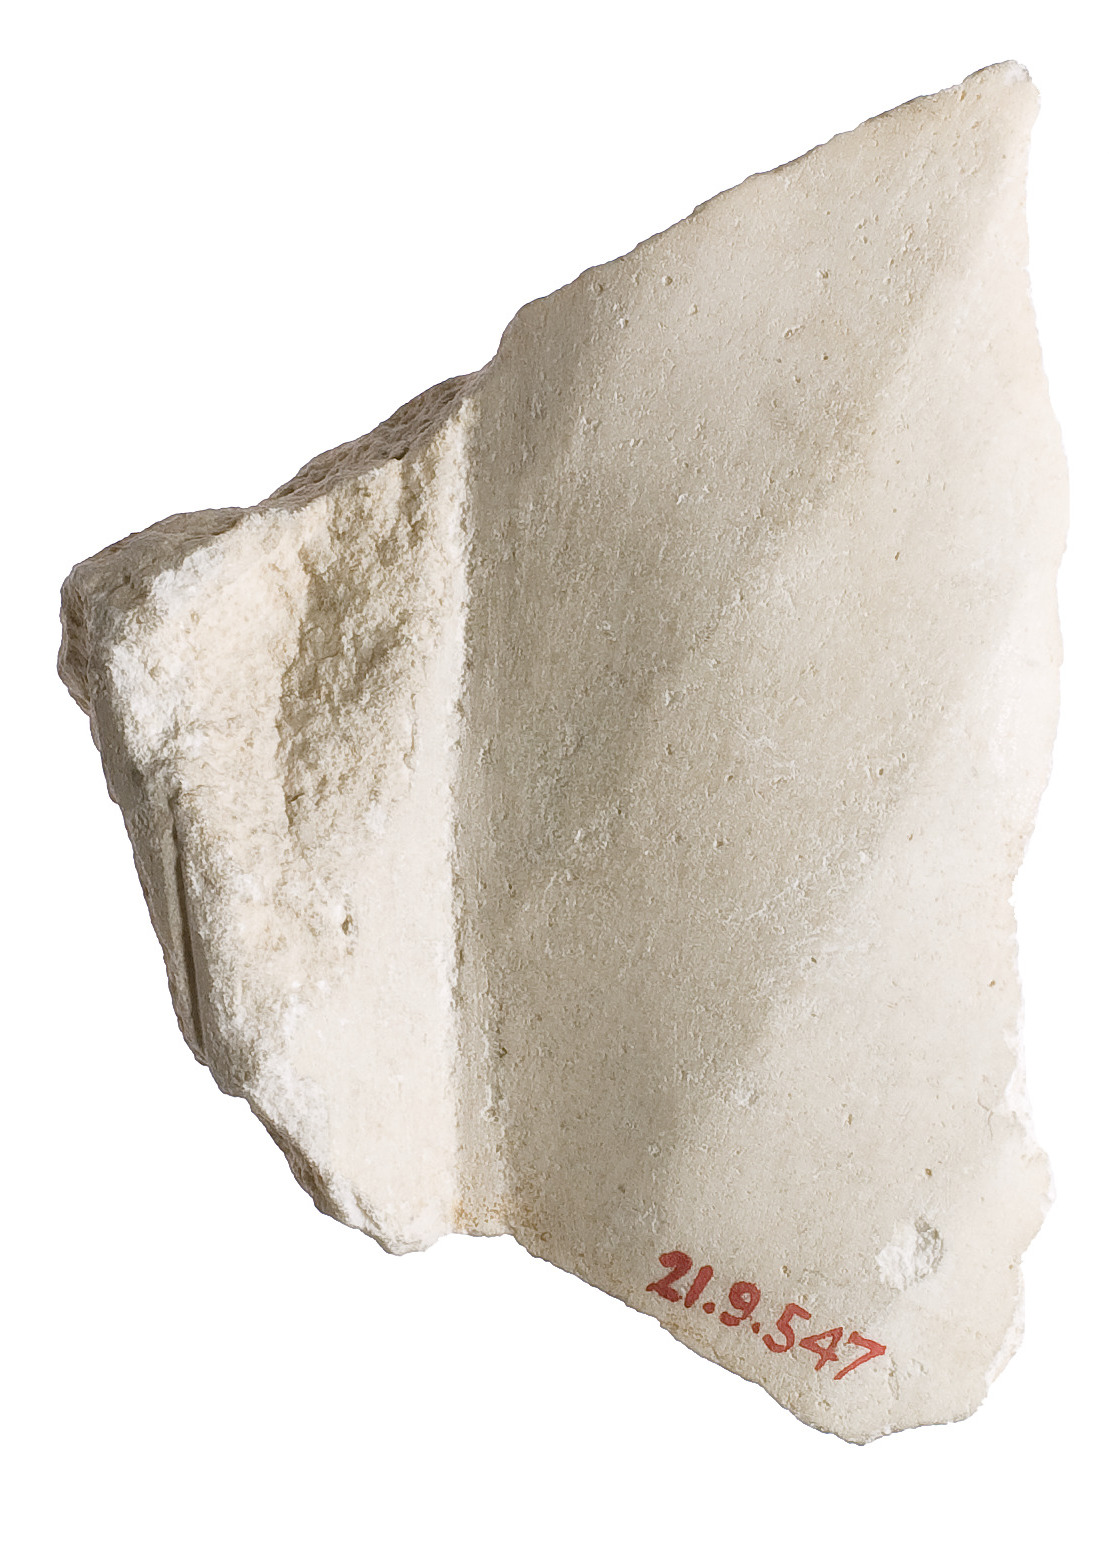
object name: body with garment, pleating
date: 1353-1336 BCE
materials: limestone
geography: egypt